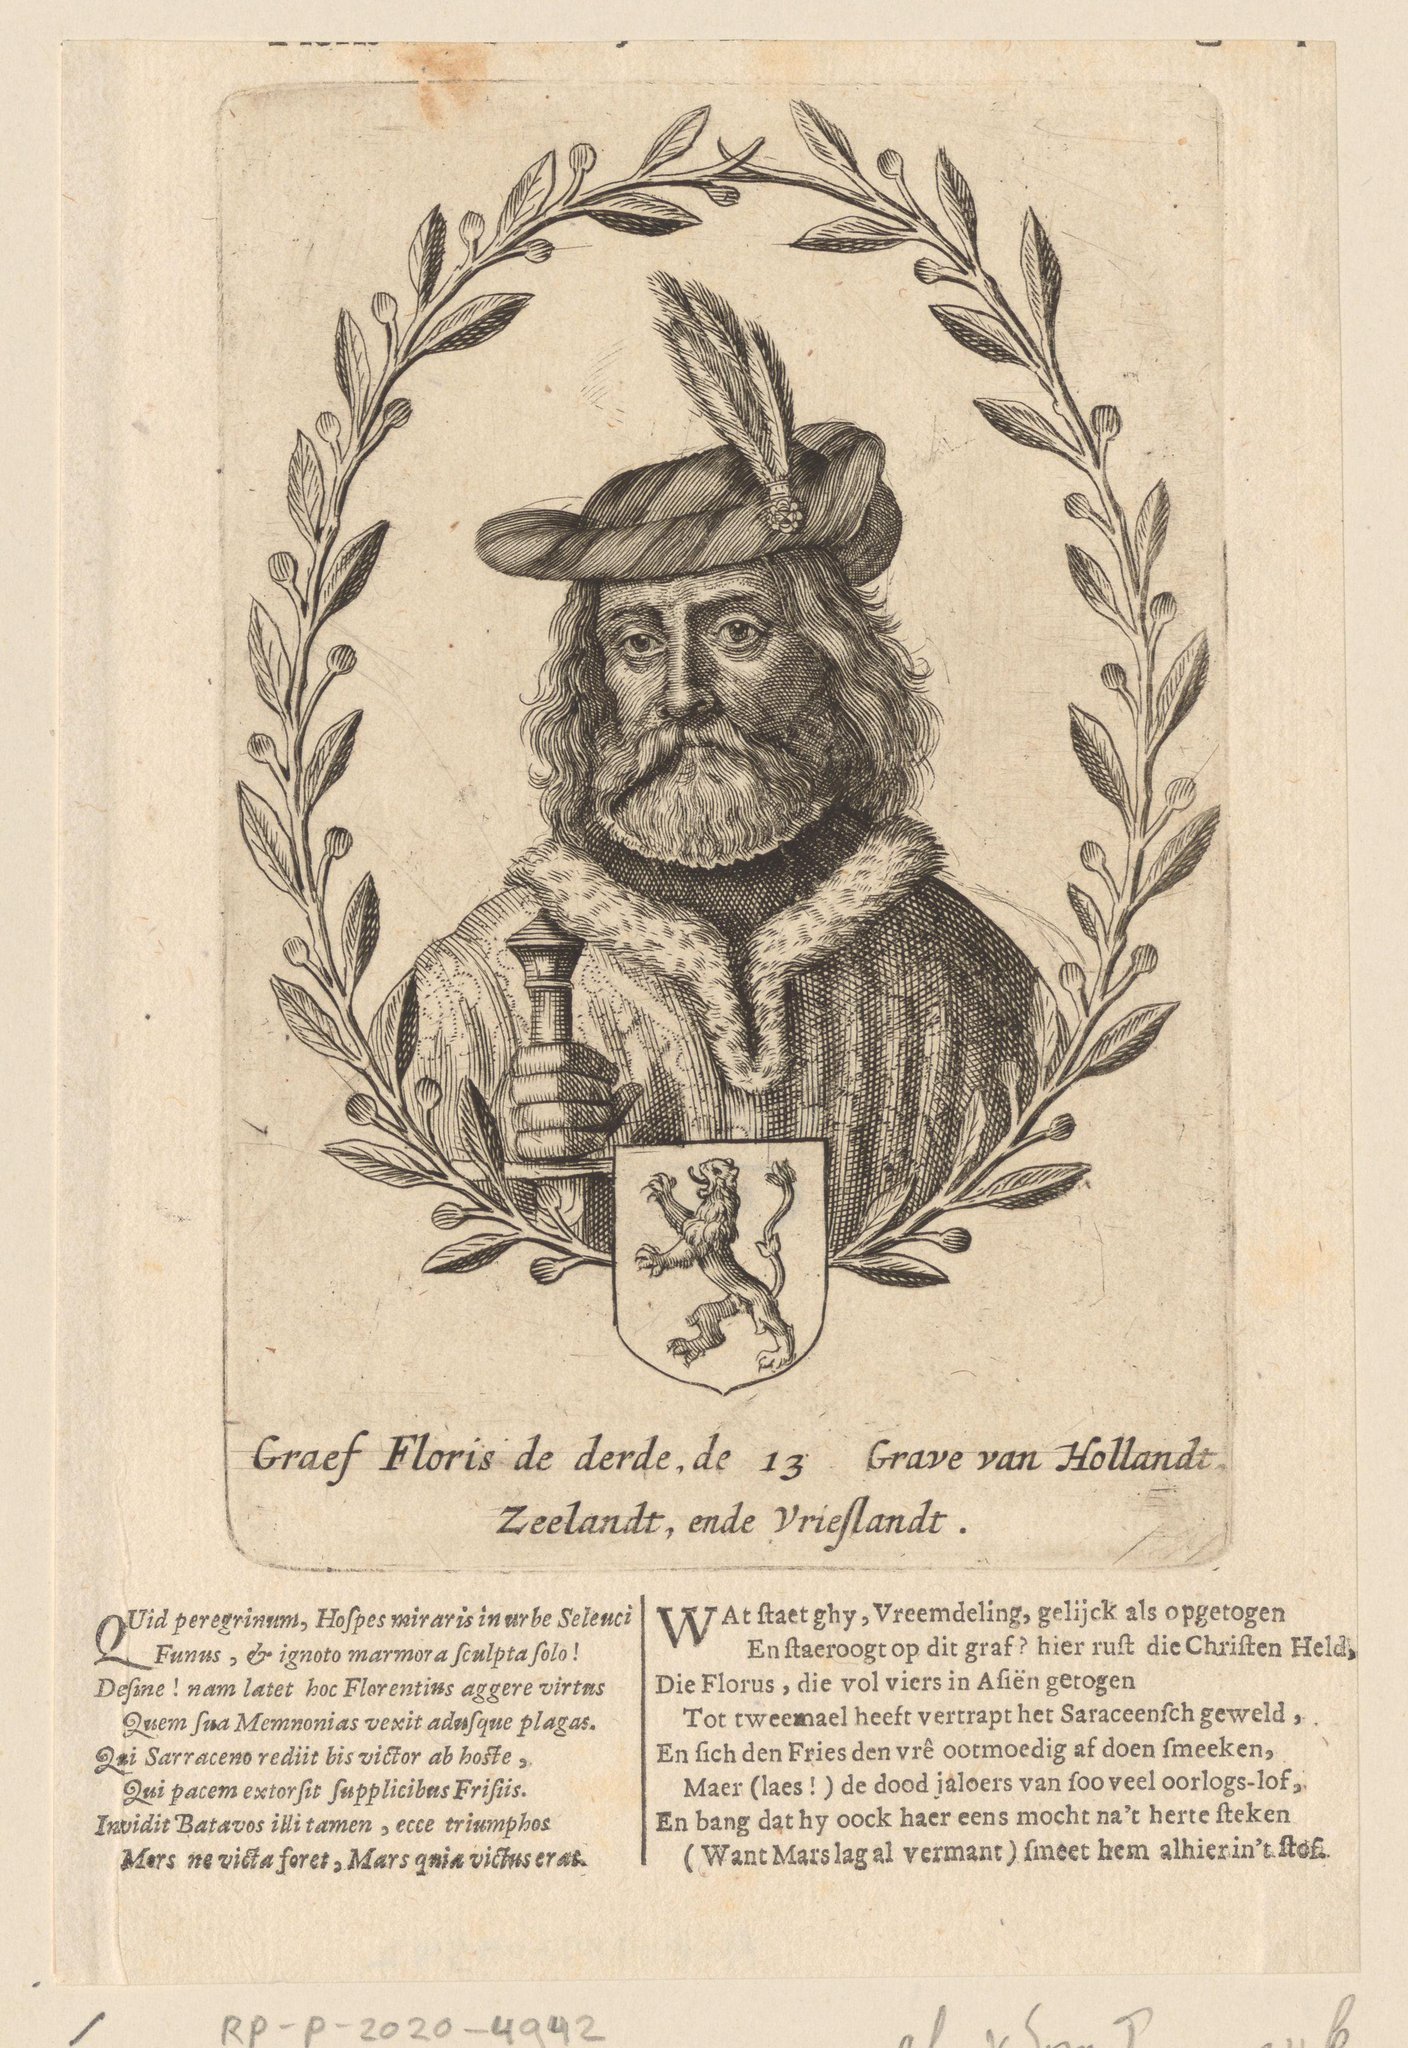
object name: print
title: Portret van Floris III, graaf van Holland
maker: Anonymous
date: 1678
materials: paper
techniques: engraving, letterpress printing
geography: northern netherlands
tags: historical persons, hacking and thrusting weapons: sword, armorial bearing, heraldry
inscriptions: collector's mark: Lugt 964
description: Prent waarschijnlijk uit: Scriverius, Petrus. Hollandsche, Zeelandsche ende Vriesche Chronyck (...). Den Haag: Johann Veely en Jasper Doll, 1678, p. 141. Eerdere staat gebruikt in 'de oude Hollandsche geschiedenissen (...)' van Wachtendorp, 1645.